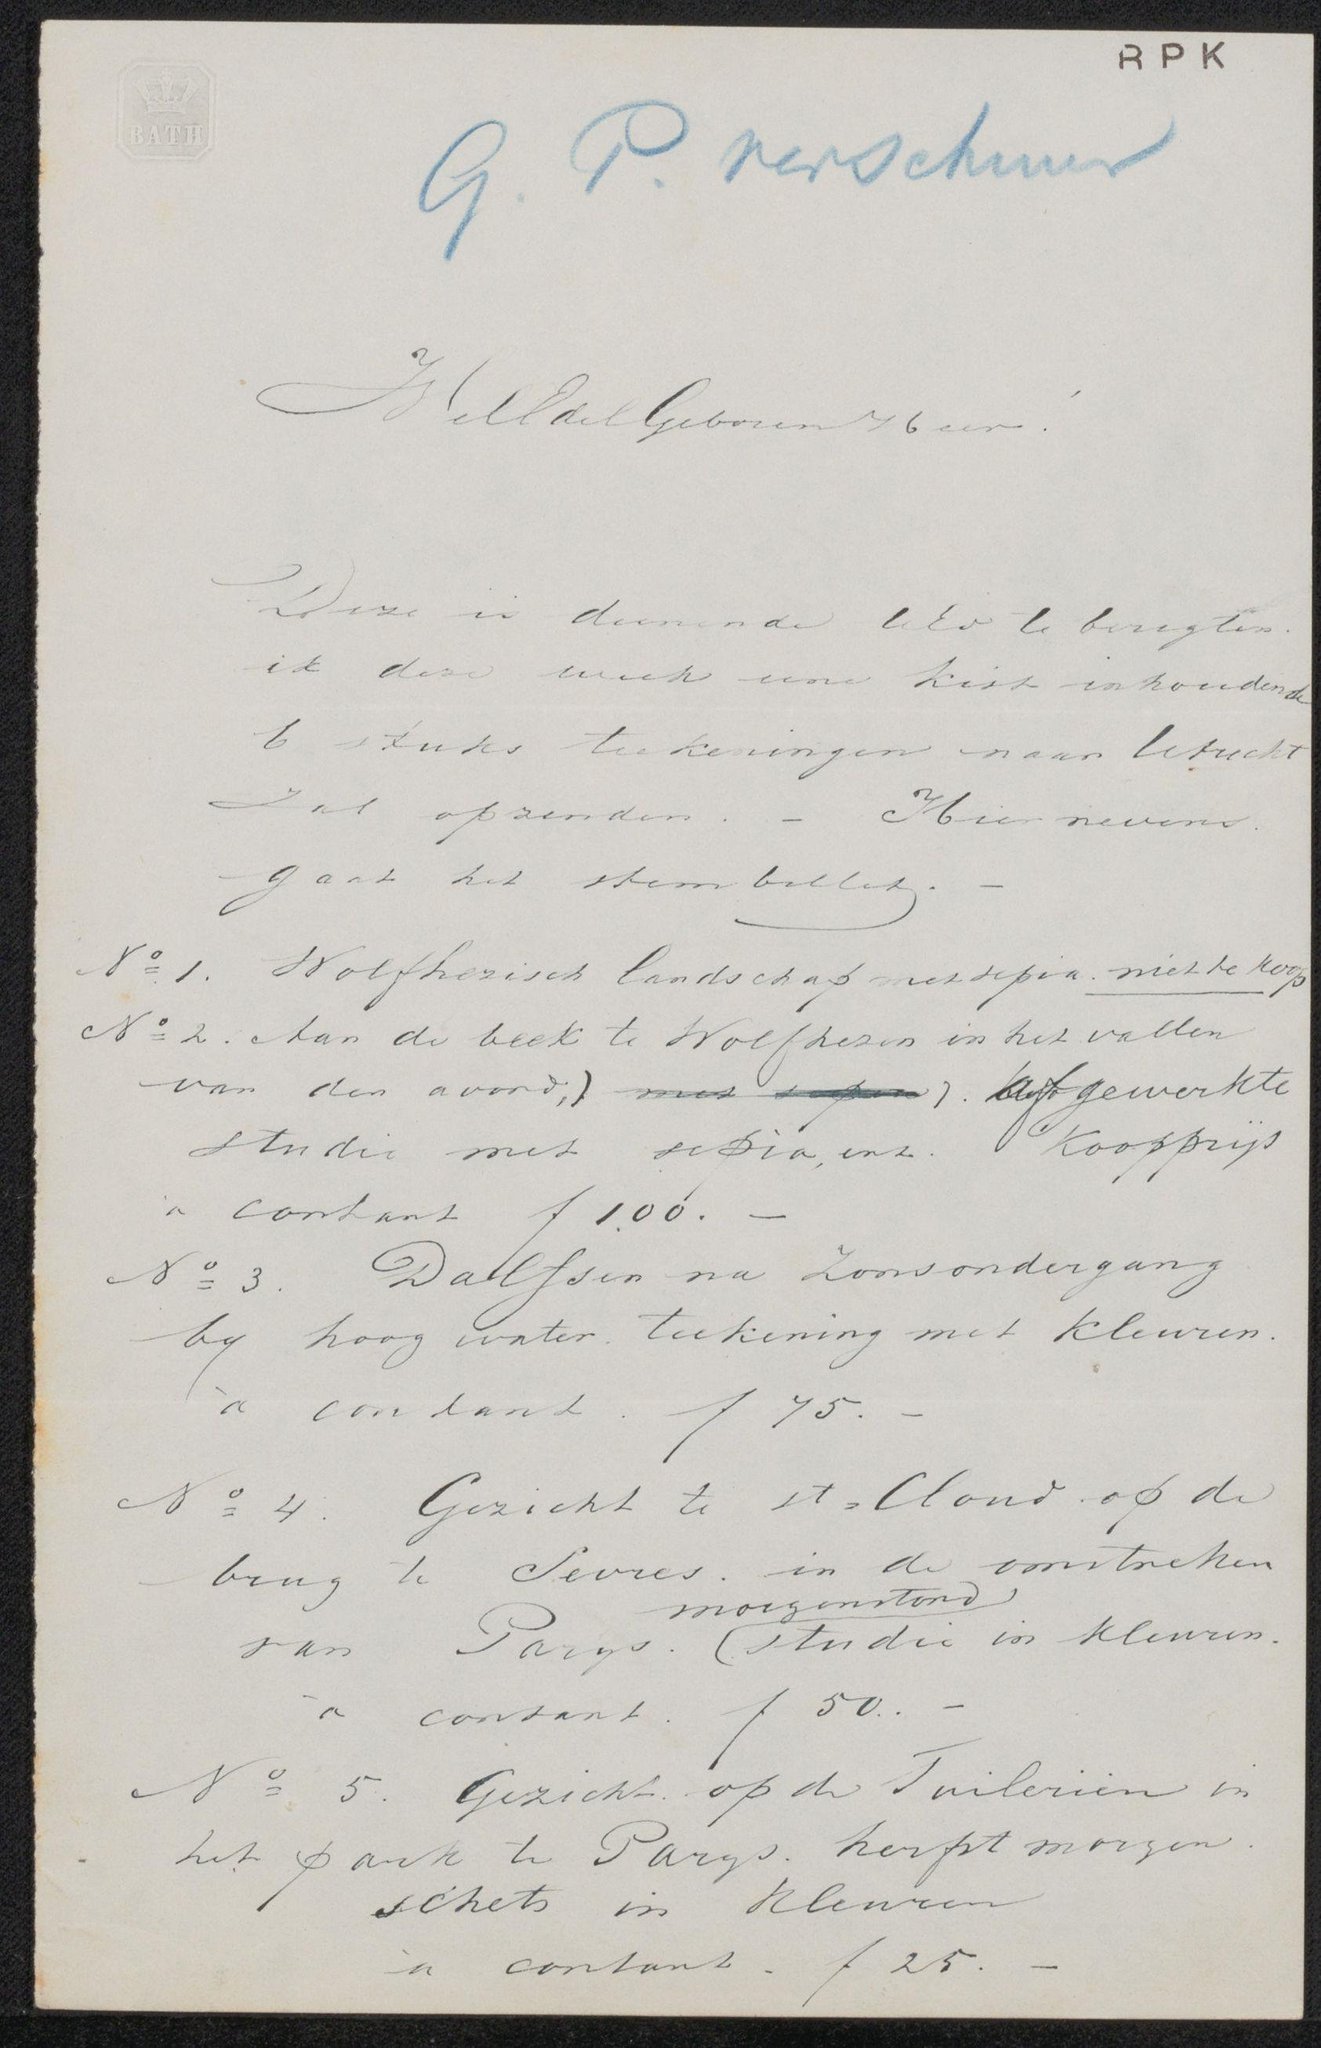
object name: letter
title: Brief aan anoniem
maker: gerrit pieter verschuur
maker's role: painter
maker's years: 1830-1891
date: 1866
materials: ink, paper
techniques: pen, writing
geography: dalfsen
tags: drawing, money, printed matter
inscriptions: collector's mark: ‘RPK’